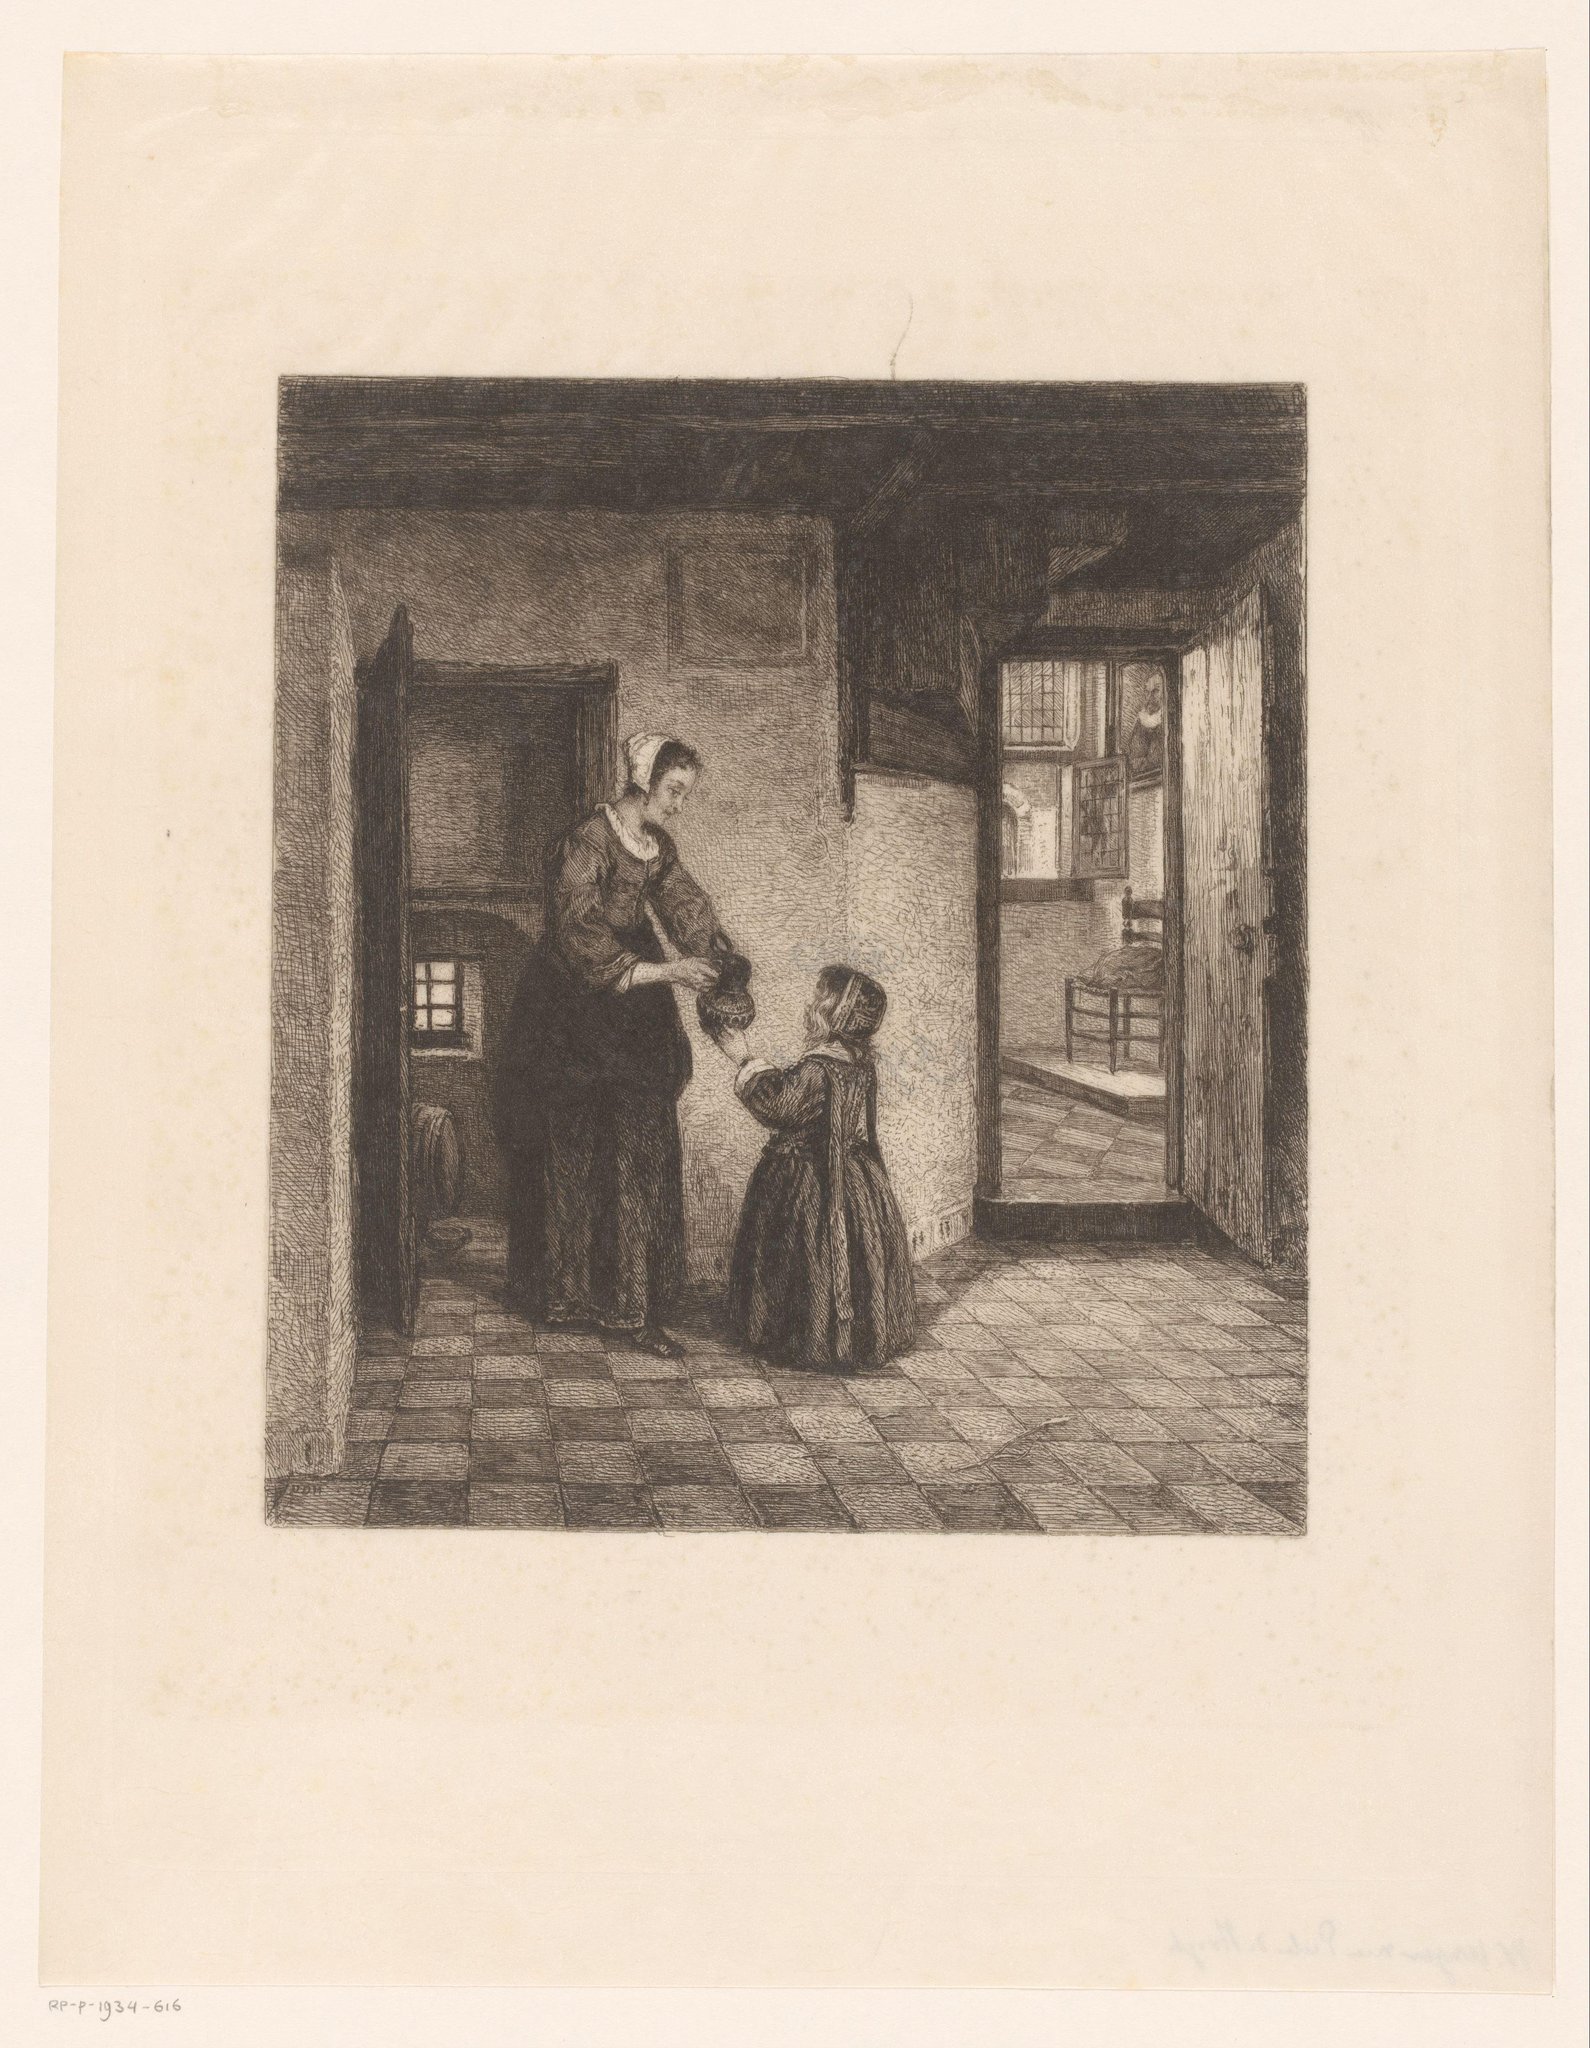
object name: print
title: Vrouw met een kind in een kelderkamer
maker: william unger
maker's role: draughtsman, painter, print maker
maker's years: 1837-1932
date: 1847-1889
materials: paper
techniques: etching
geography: germany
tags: girl (child between toddler and youth), interior of the house, container of metal: bucket, can, canister, drum, tin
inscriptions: collector's mark: Lugt 2228